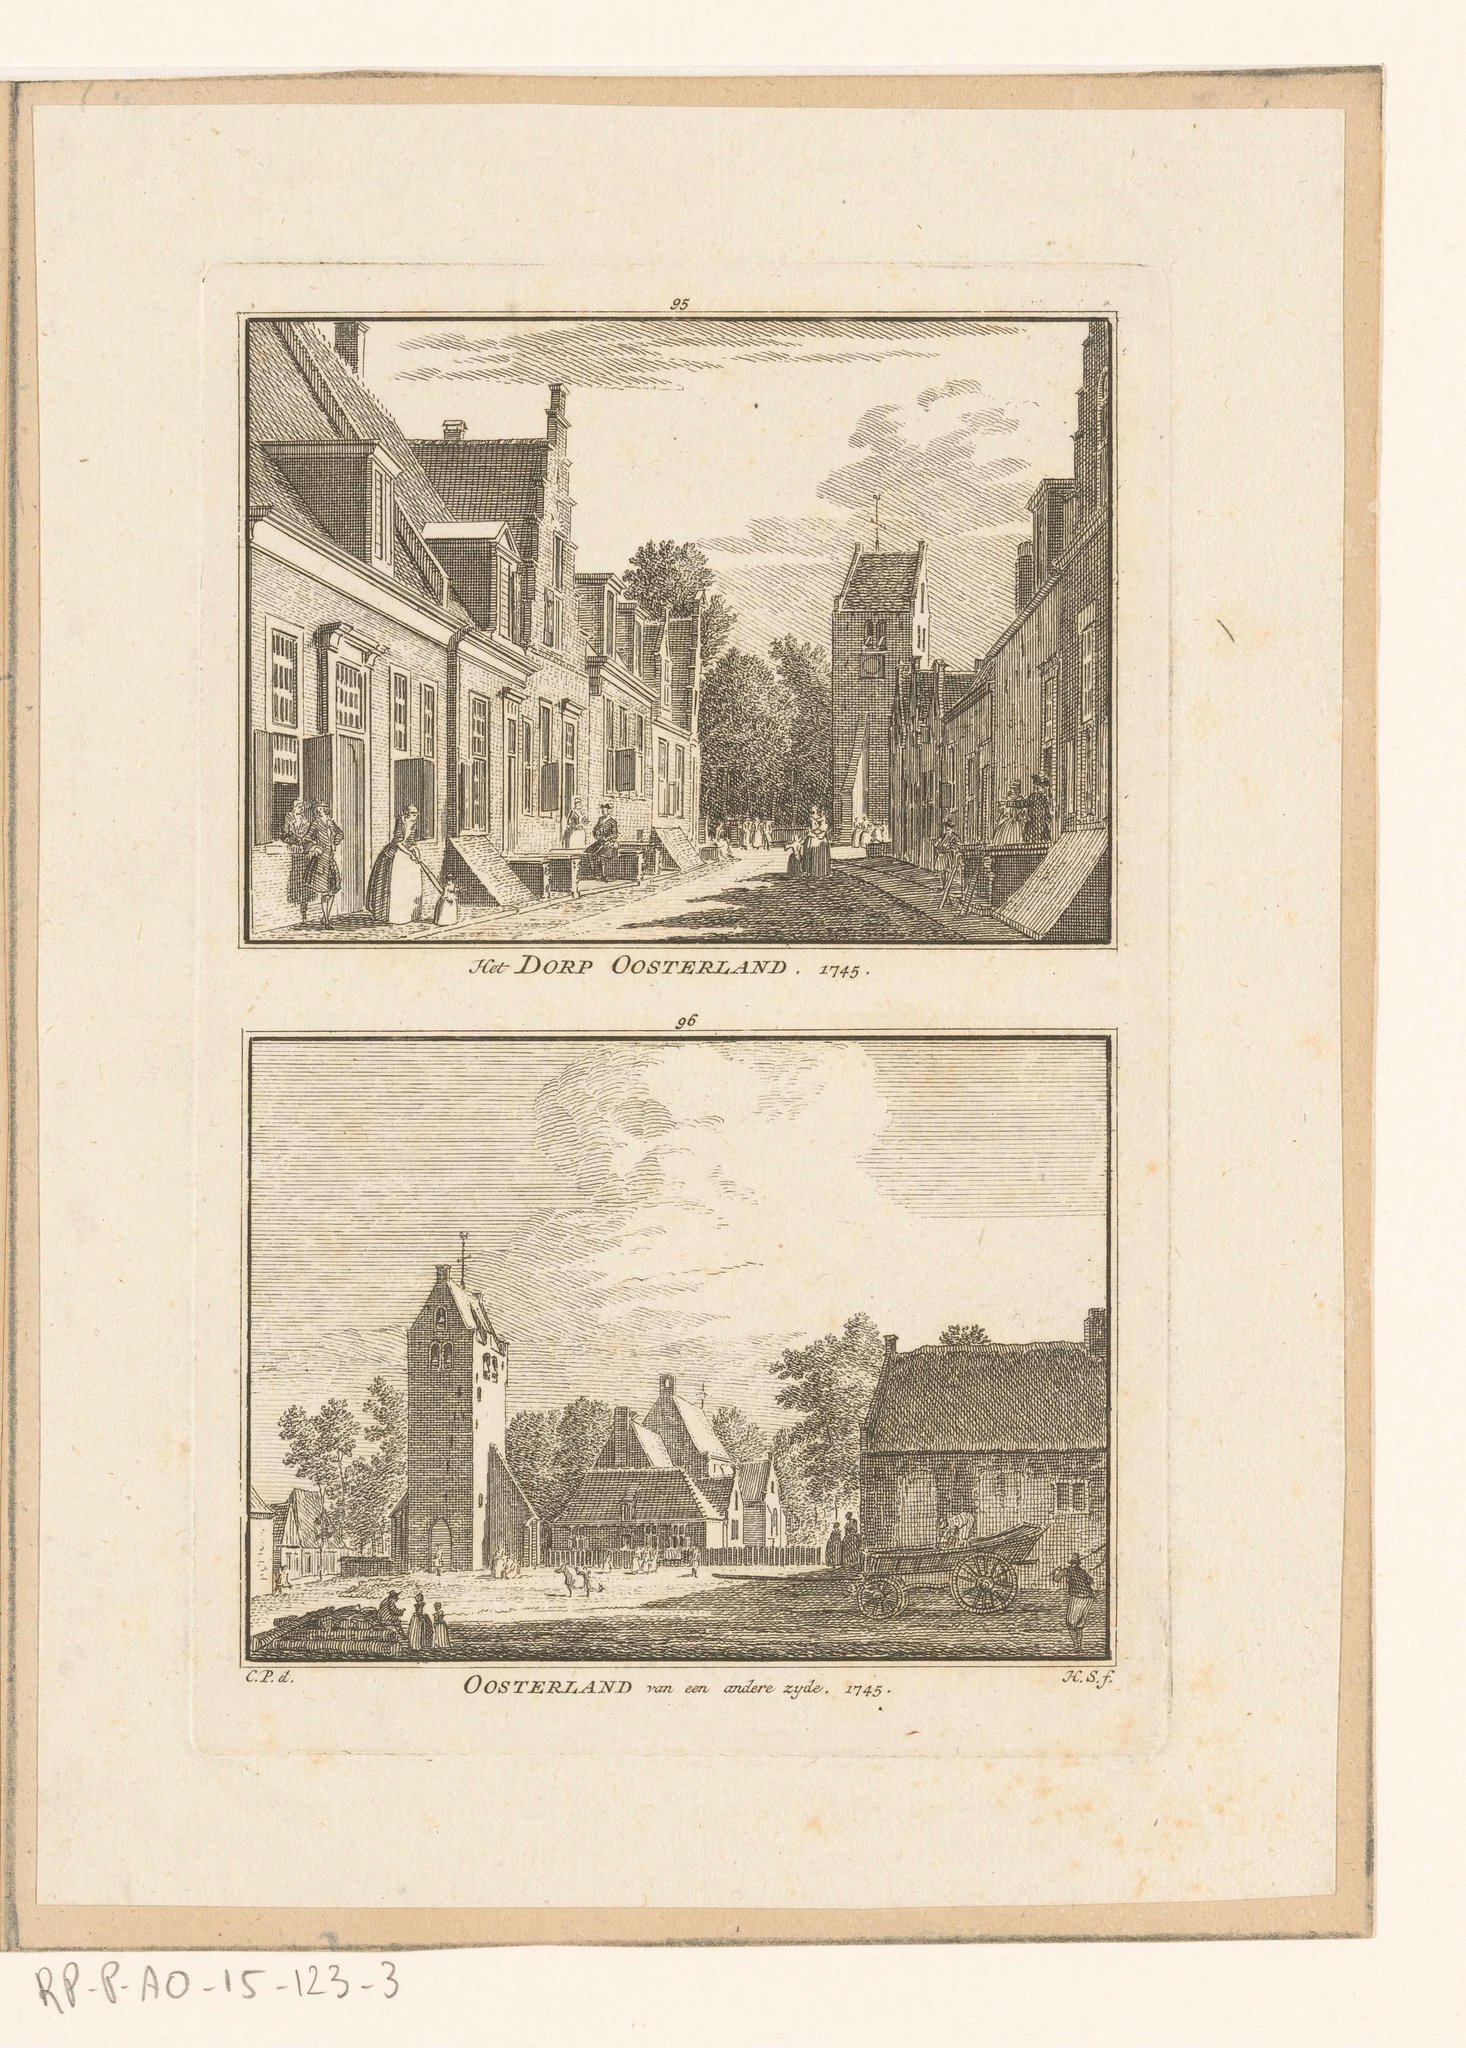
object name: book illustration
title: Het Dorp Oosterland. 1745 / Oosterland van een andere zyde. 1745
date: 1754-1792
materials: paper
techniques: etching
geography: haarlem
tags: prospect of village, silhouette of village, church (exterior)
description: Prent ook gebruikt in: Het verheerlykt Nederland of kabinet van hedendaagsche gezigten van steden, dorpen (…). 9 delen. Amsterdam: Isaak Tirion en weduwe Isaak Tirion, 1745-1774, dl. 5 (1754), ill. 95 en 96. Of in: Nederlandsche tafereelen; of eene keurige verzameling van negen honderd fraaije gezigten van steden, dorpen, sloten, oudheden [….]. 9 delen. Amsterdam: Jan de Groot, 1792, dl. 5, ill. 95 en 96.